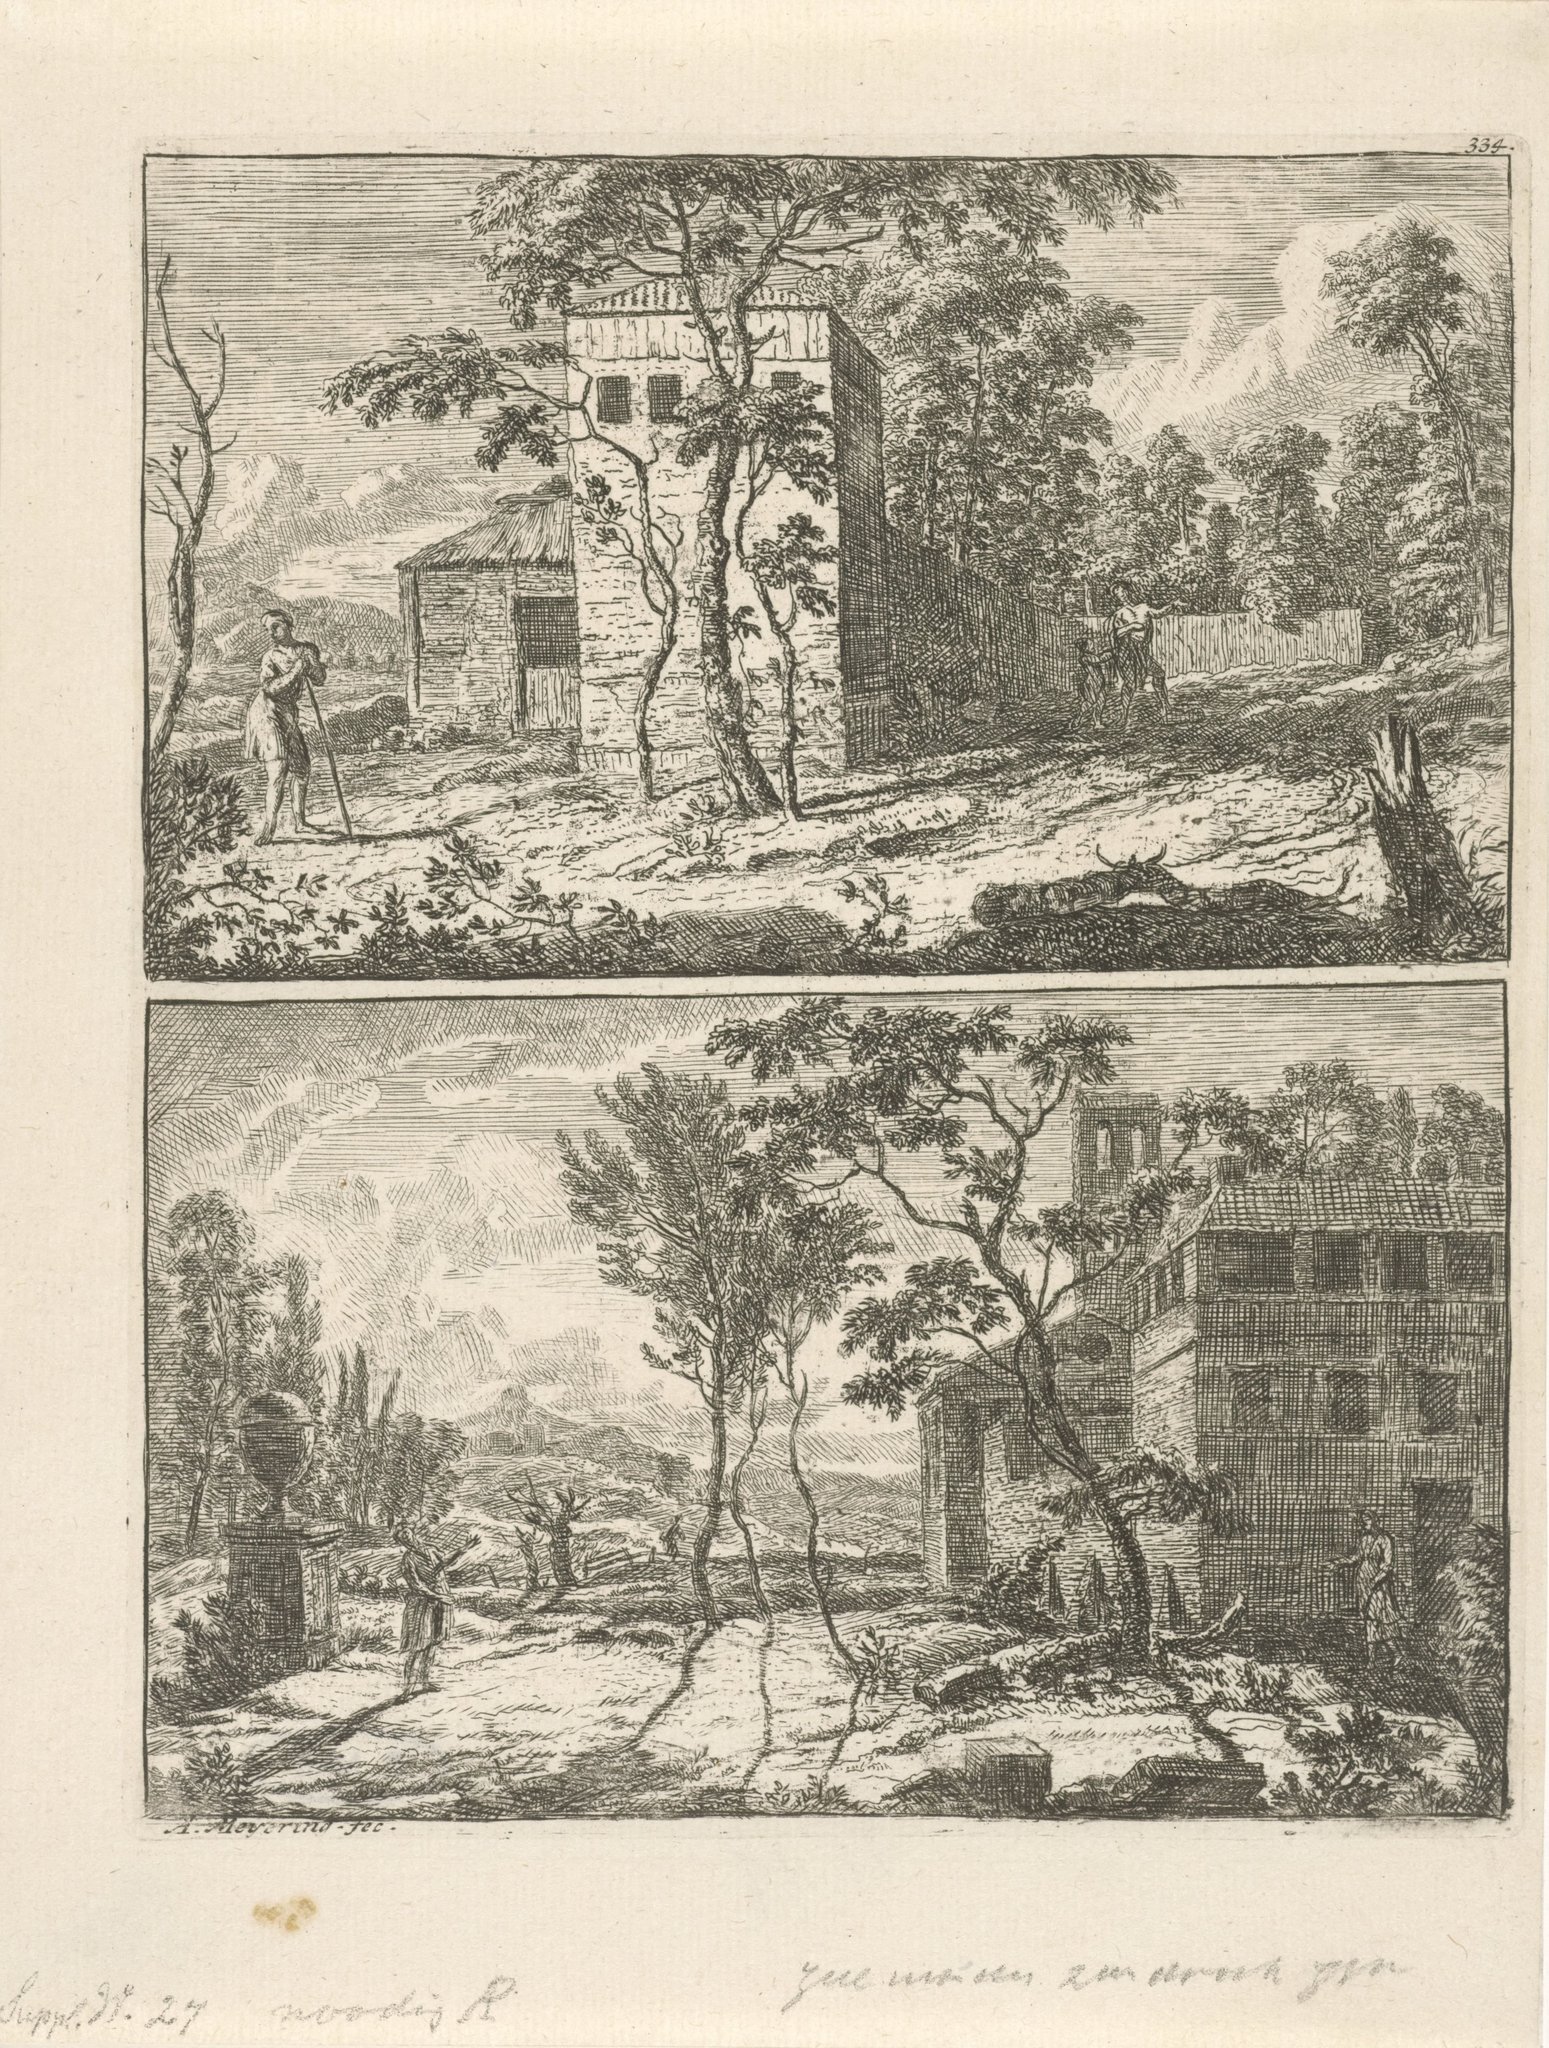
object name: print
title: Twee landschappen met gebouwen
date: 1707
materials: paper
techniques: engraving, etching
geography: amsterdam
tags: landscapes in the temperate zone (+ landscape with figures, staffage), farm or solitary house in landscape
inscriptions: collector's mark: Lugt 2228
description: Twee landschappen. Boven een landschap met een gebouw en een man leunend op een stok. Onder een landschap met links een man bij een monumentale tuinvaas en rechts een gebouw. Rechtsboven genummerd: 334.